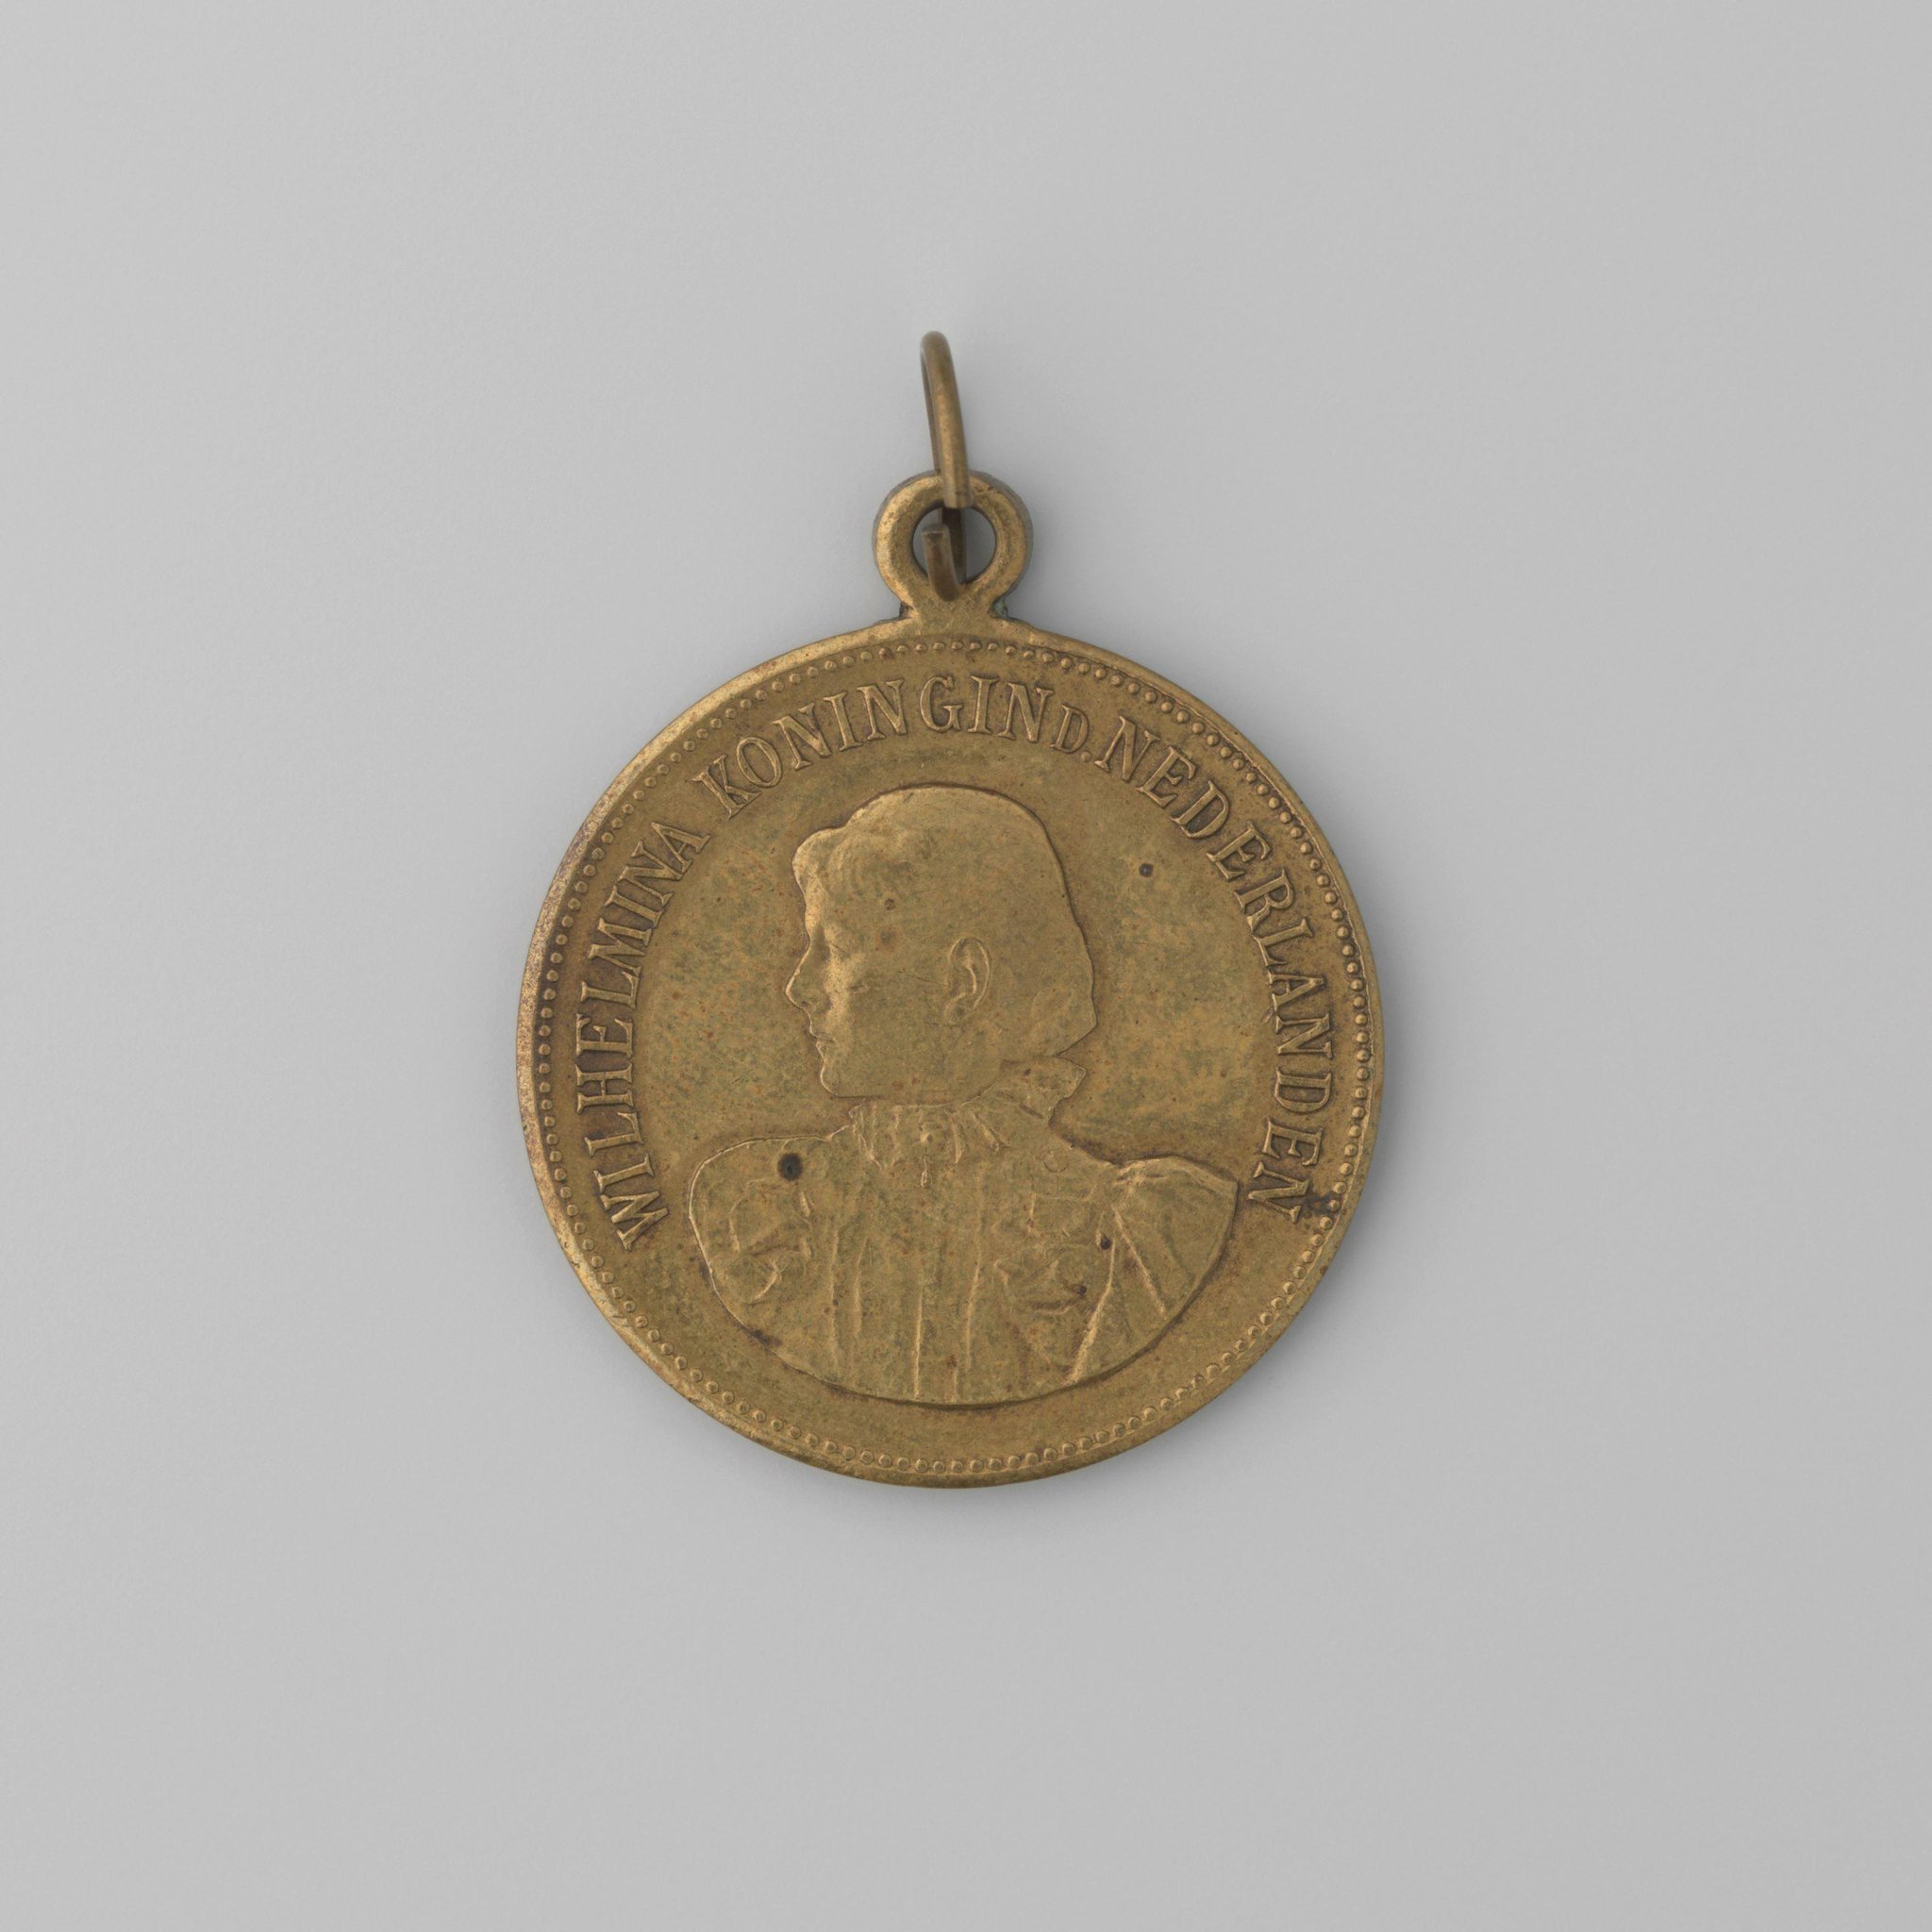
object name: insignia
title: Draagteken met beeldenaar Wilhelmina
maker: Anonymous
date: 1898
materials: bronze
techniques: gilding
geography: netherlands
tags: wilhelmina of the netherlands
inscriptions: : ‘DE LIEFDE VAN HAAR VOLK ZIJ HAAR KROON 1898’, : ‘WILHELMINA KONINGIN D. NEDERLANDEN’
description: Draagteken van verguld brons met draadoog met beeldenaar van Wilhelmina.